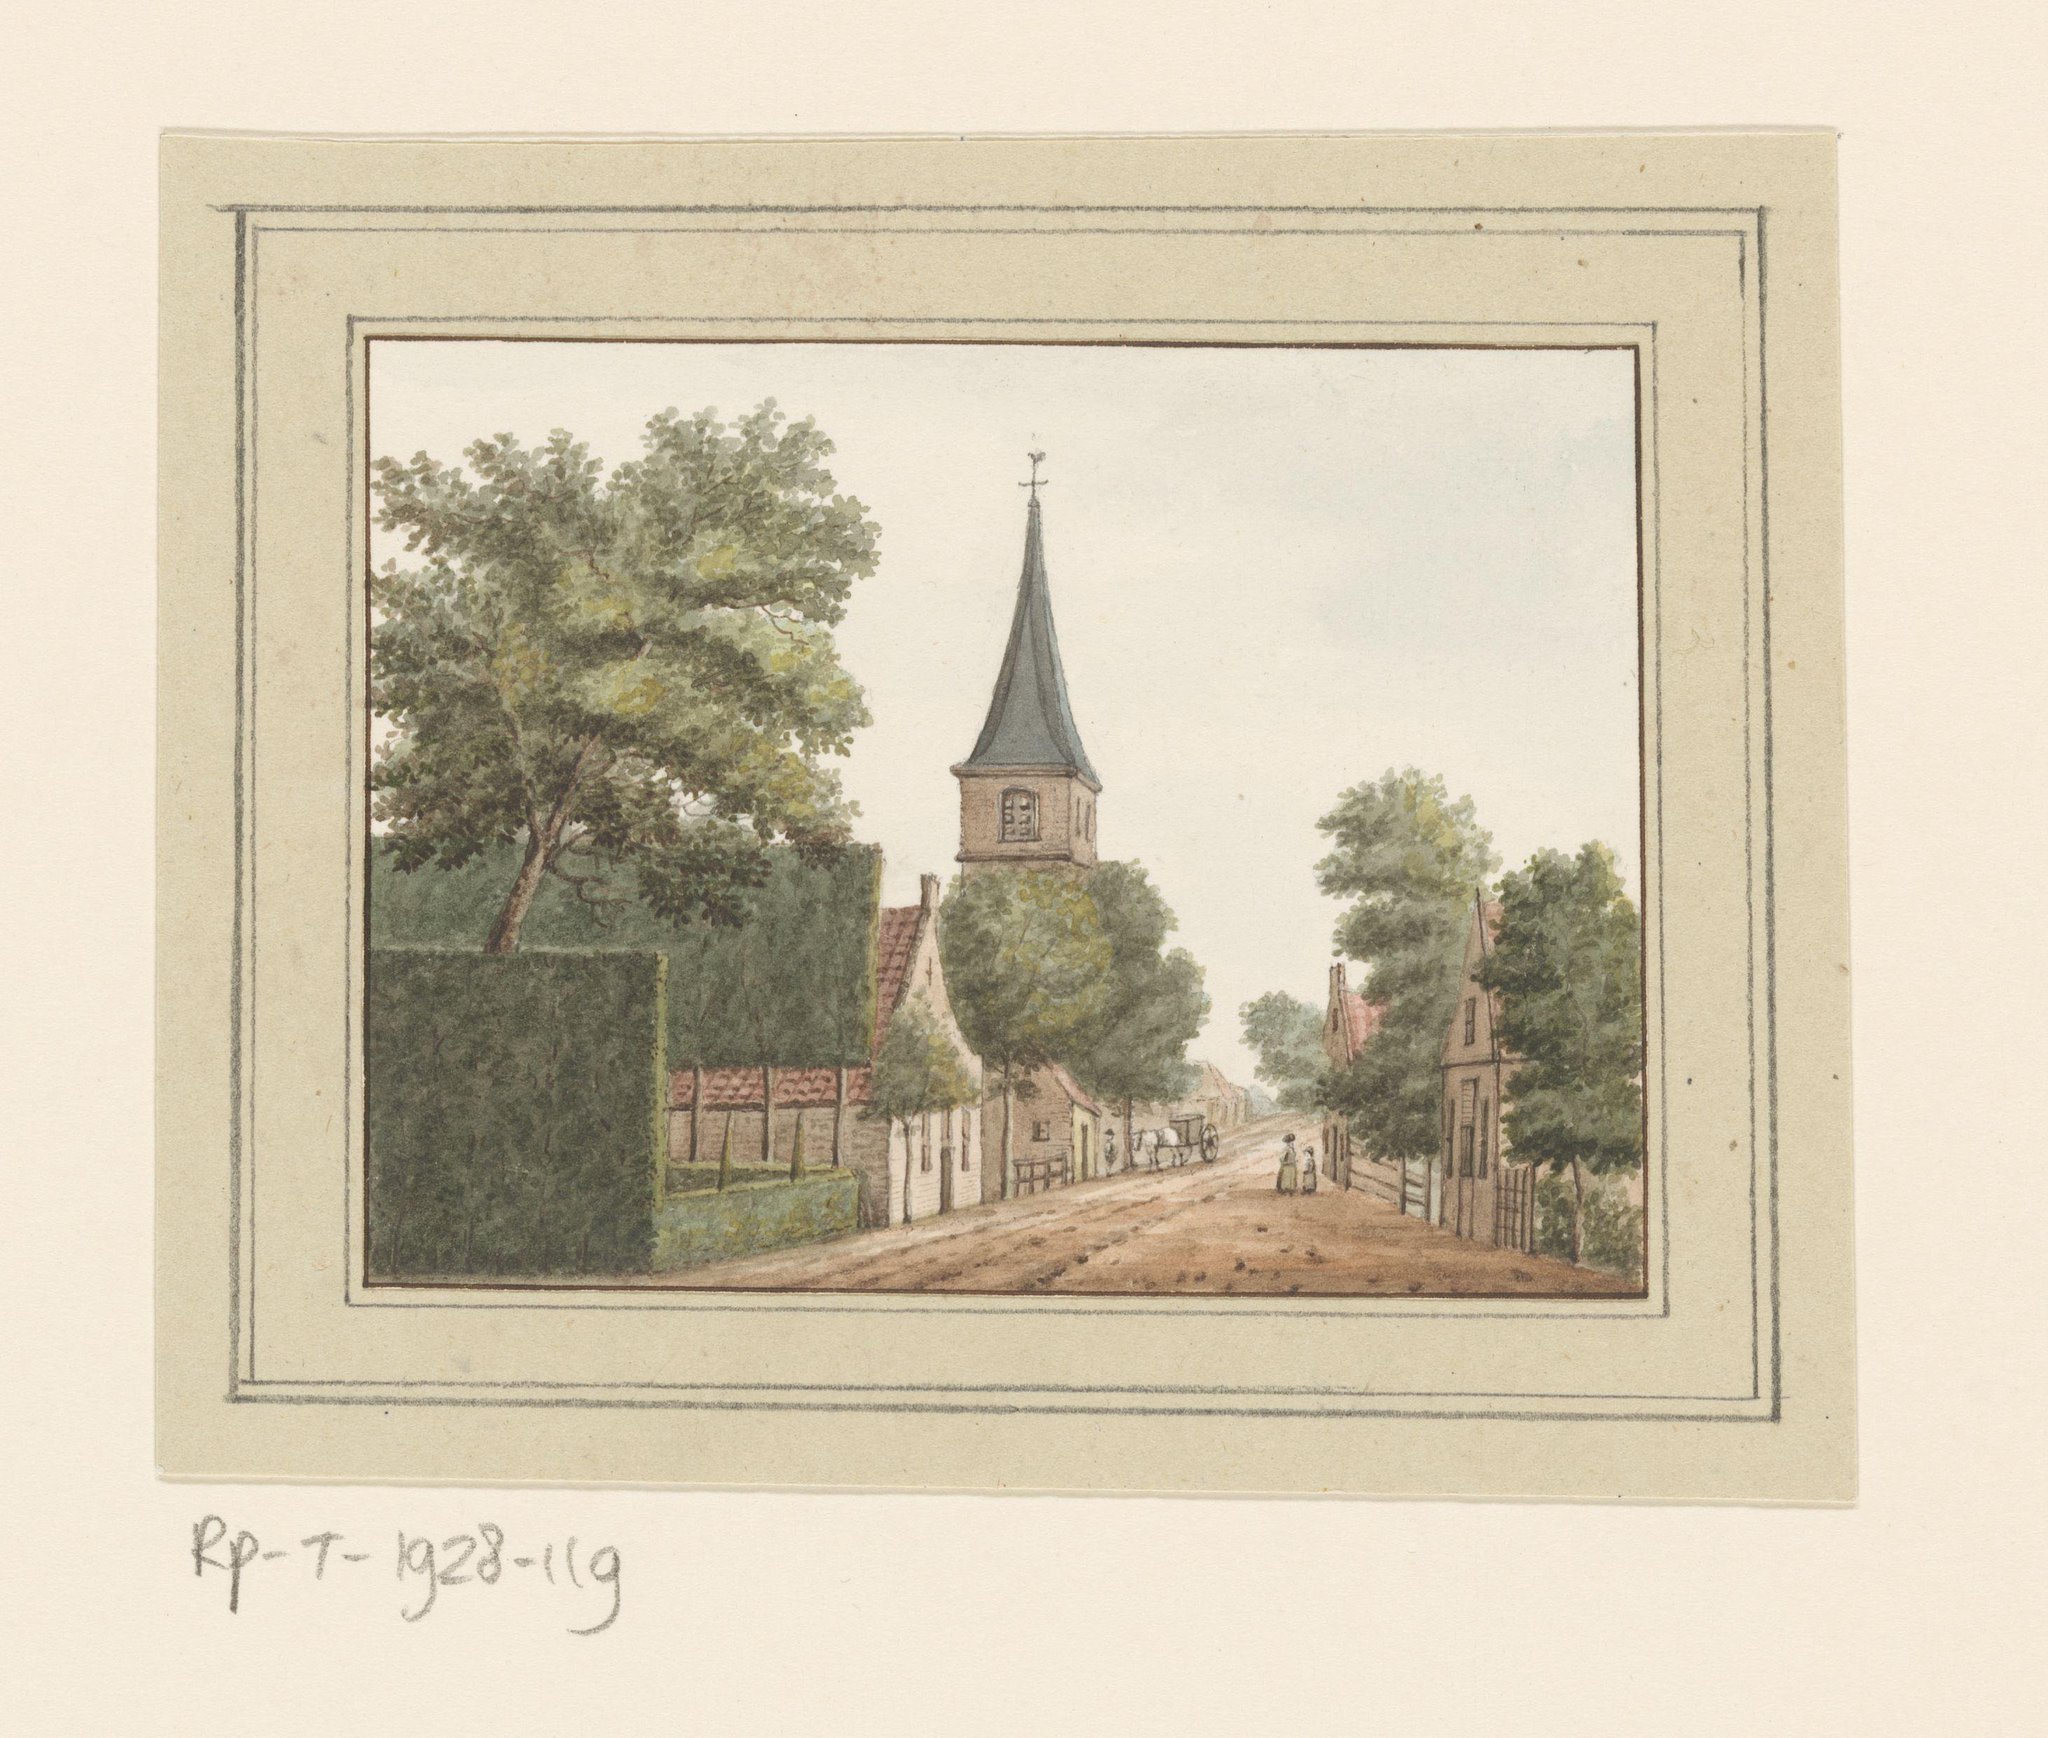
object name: drawing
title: Gezicht op het dorp Heemskerk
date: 1752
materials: ink, paper, watercolor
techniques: brush, pen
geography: haarlem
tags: village, public road in village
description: Mogelijk een kopie naar de prent van Hendrik Spilman, zie RP-P-1905-5877.